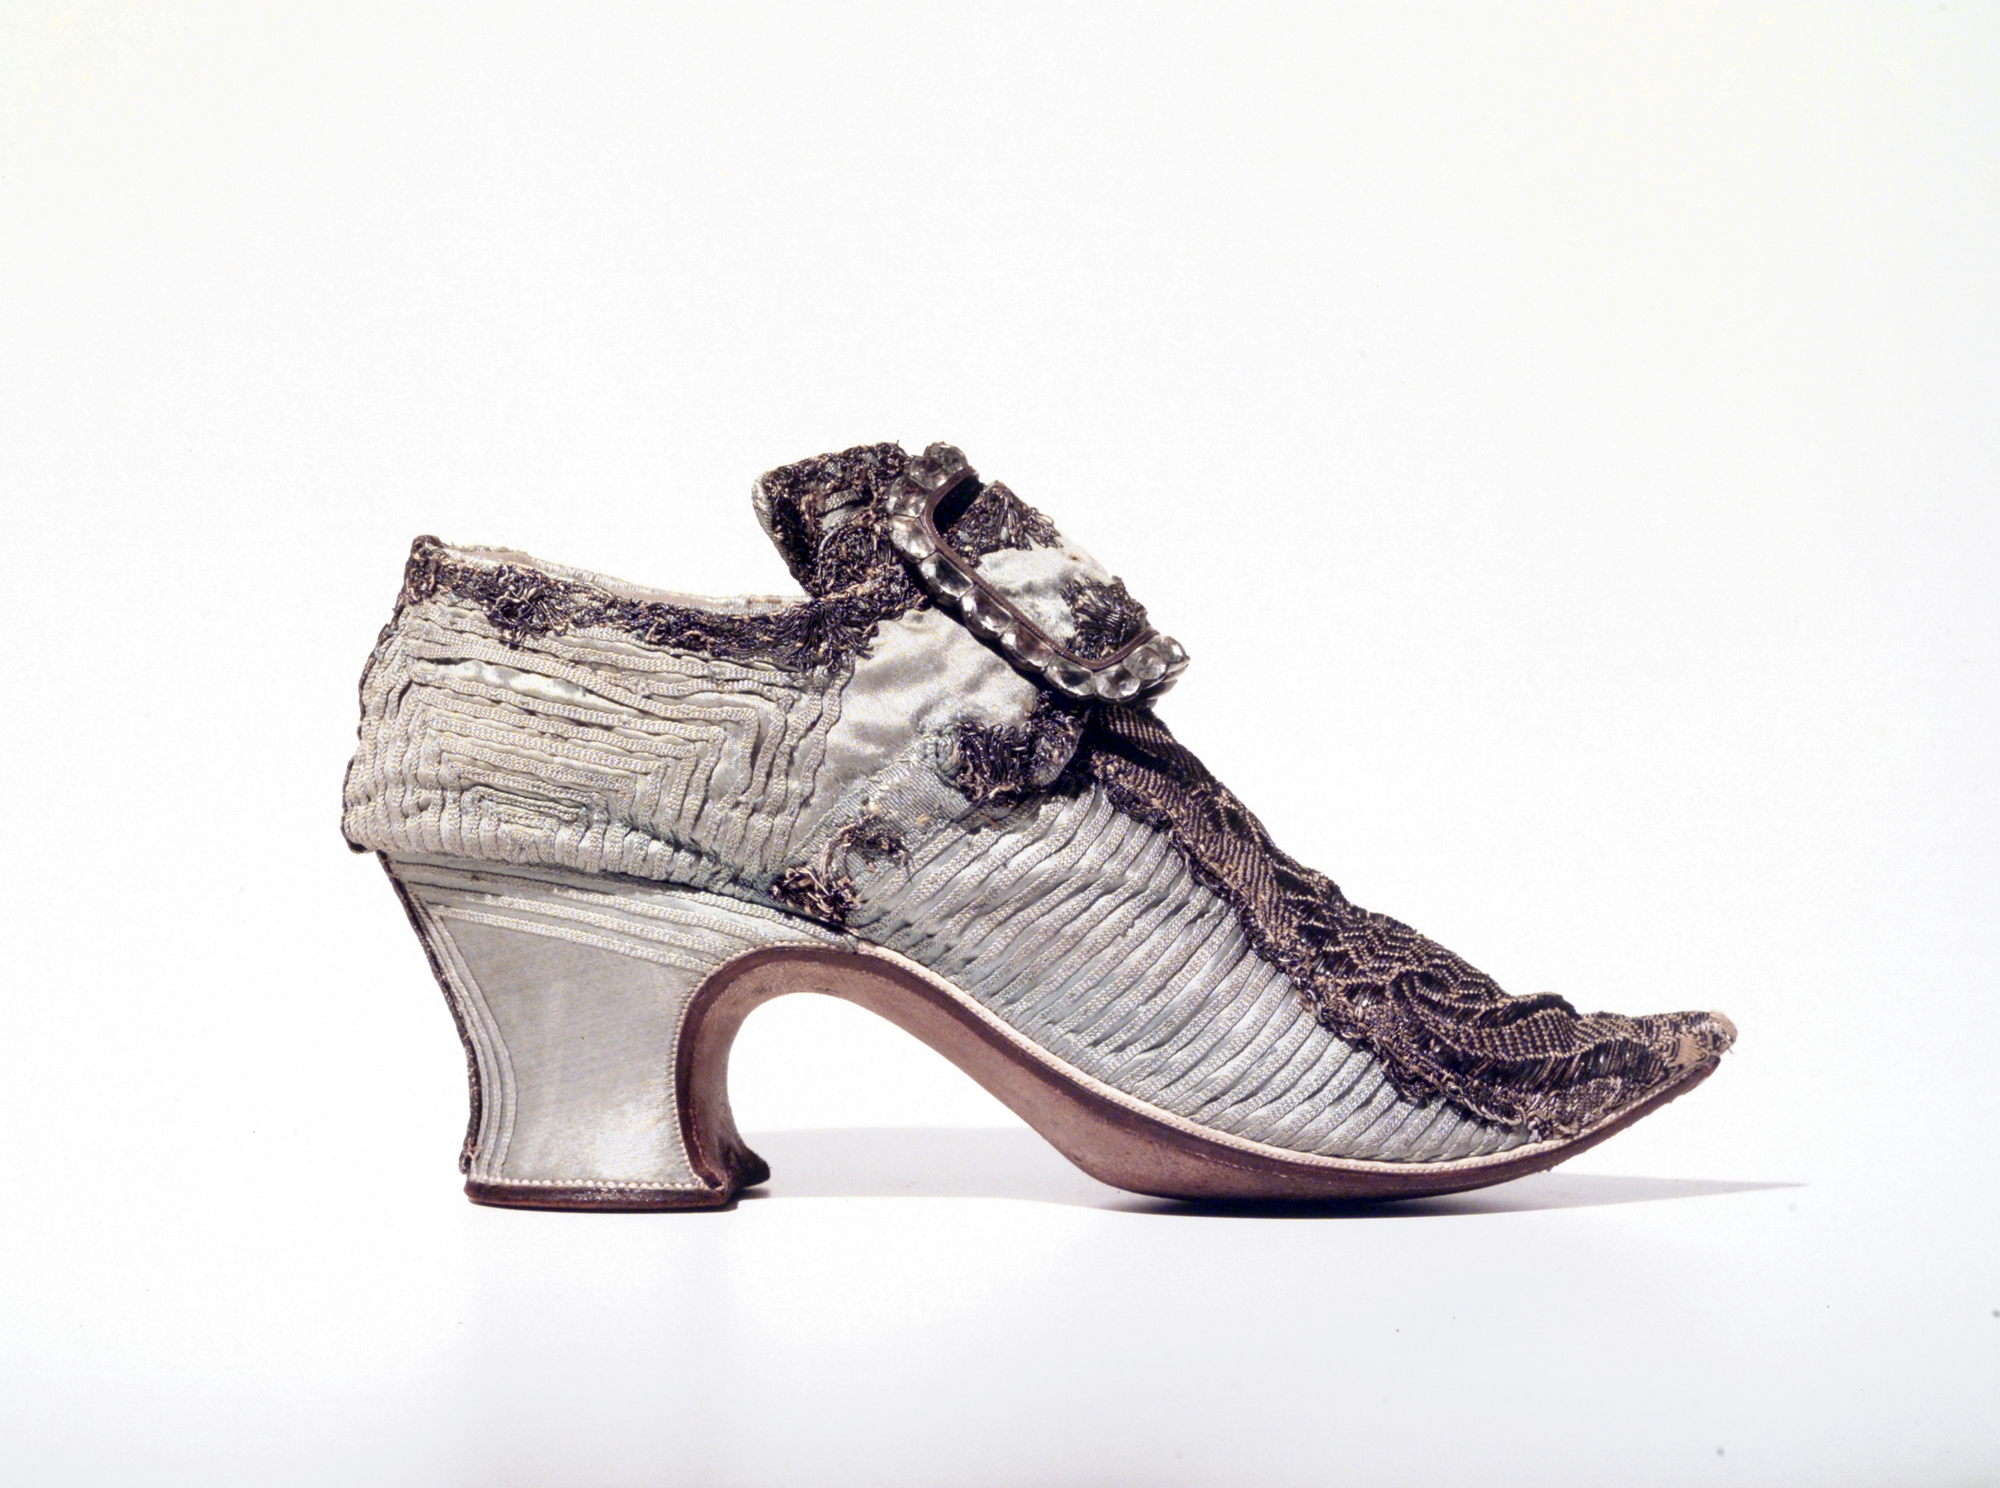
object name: shoe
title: Shoes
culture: british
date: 1700-1729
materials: silk